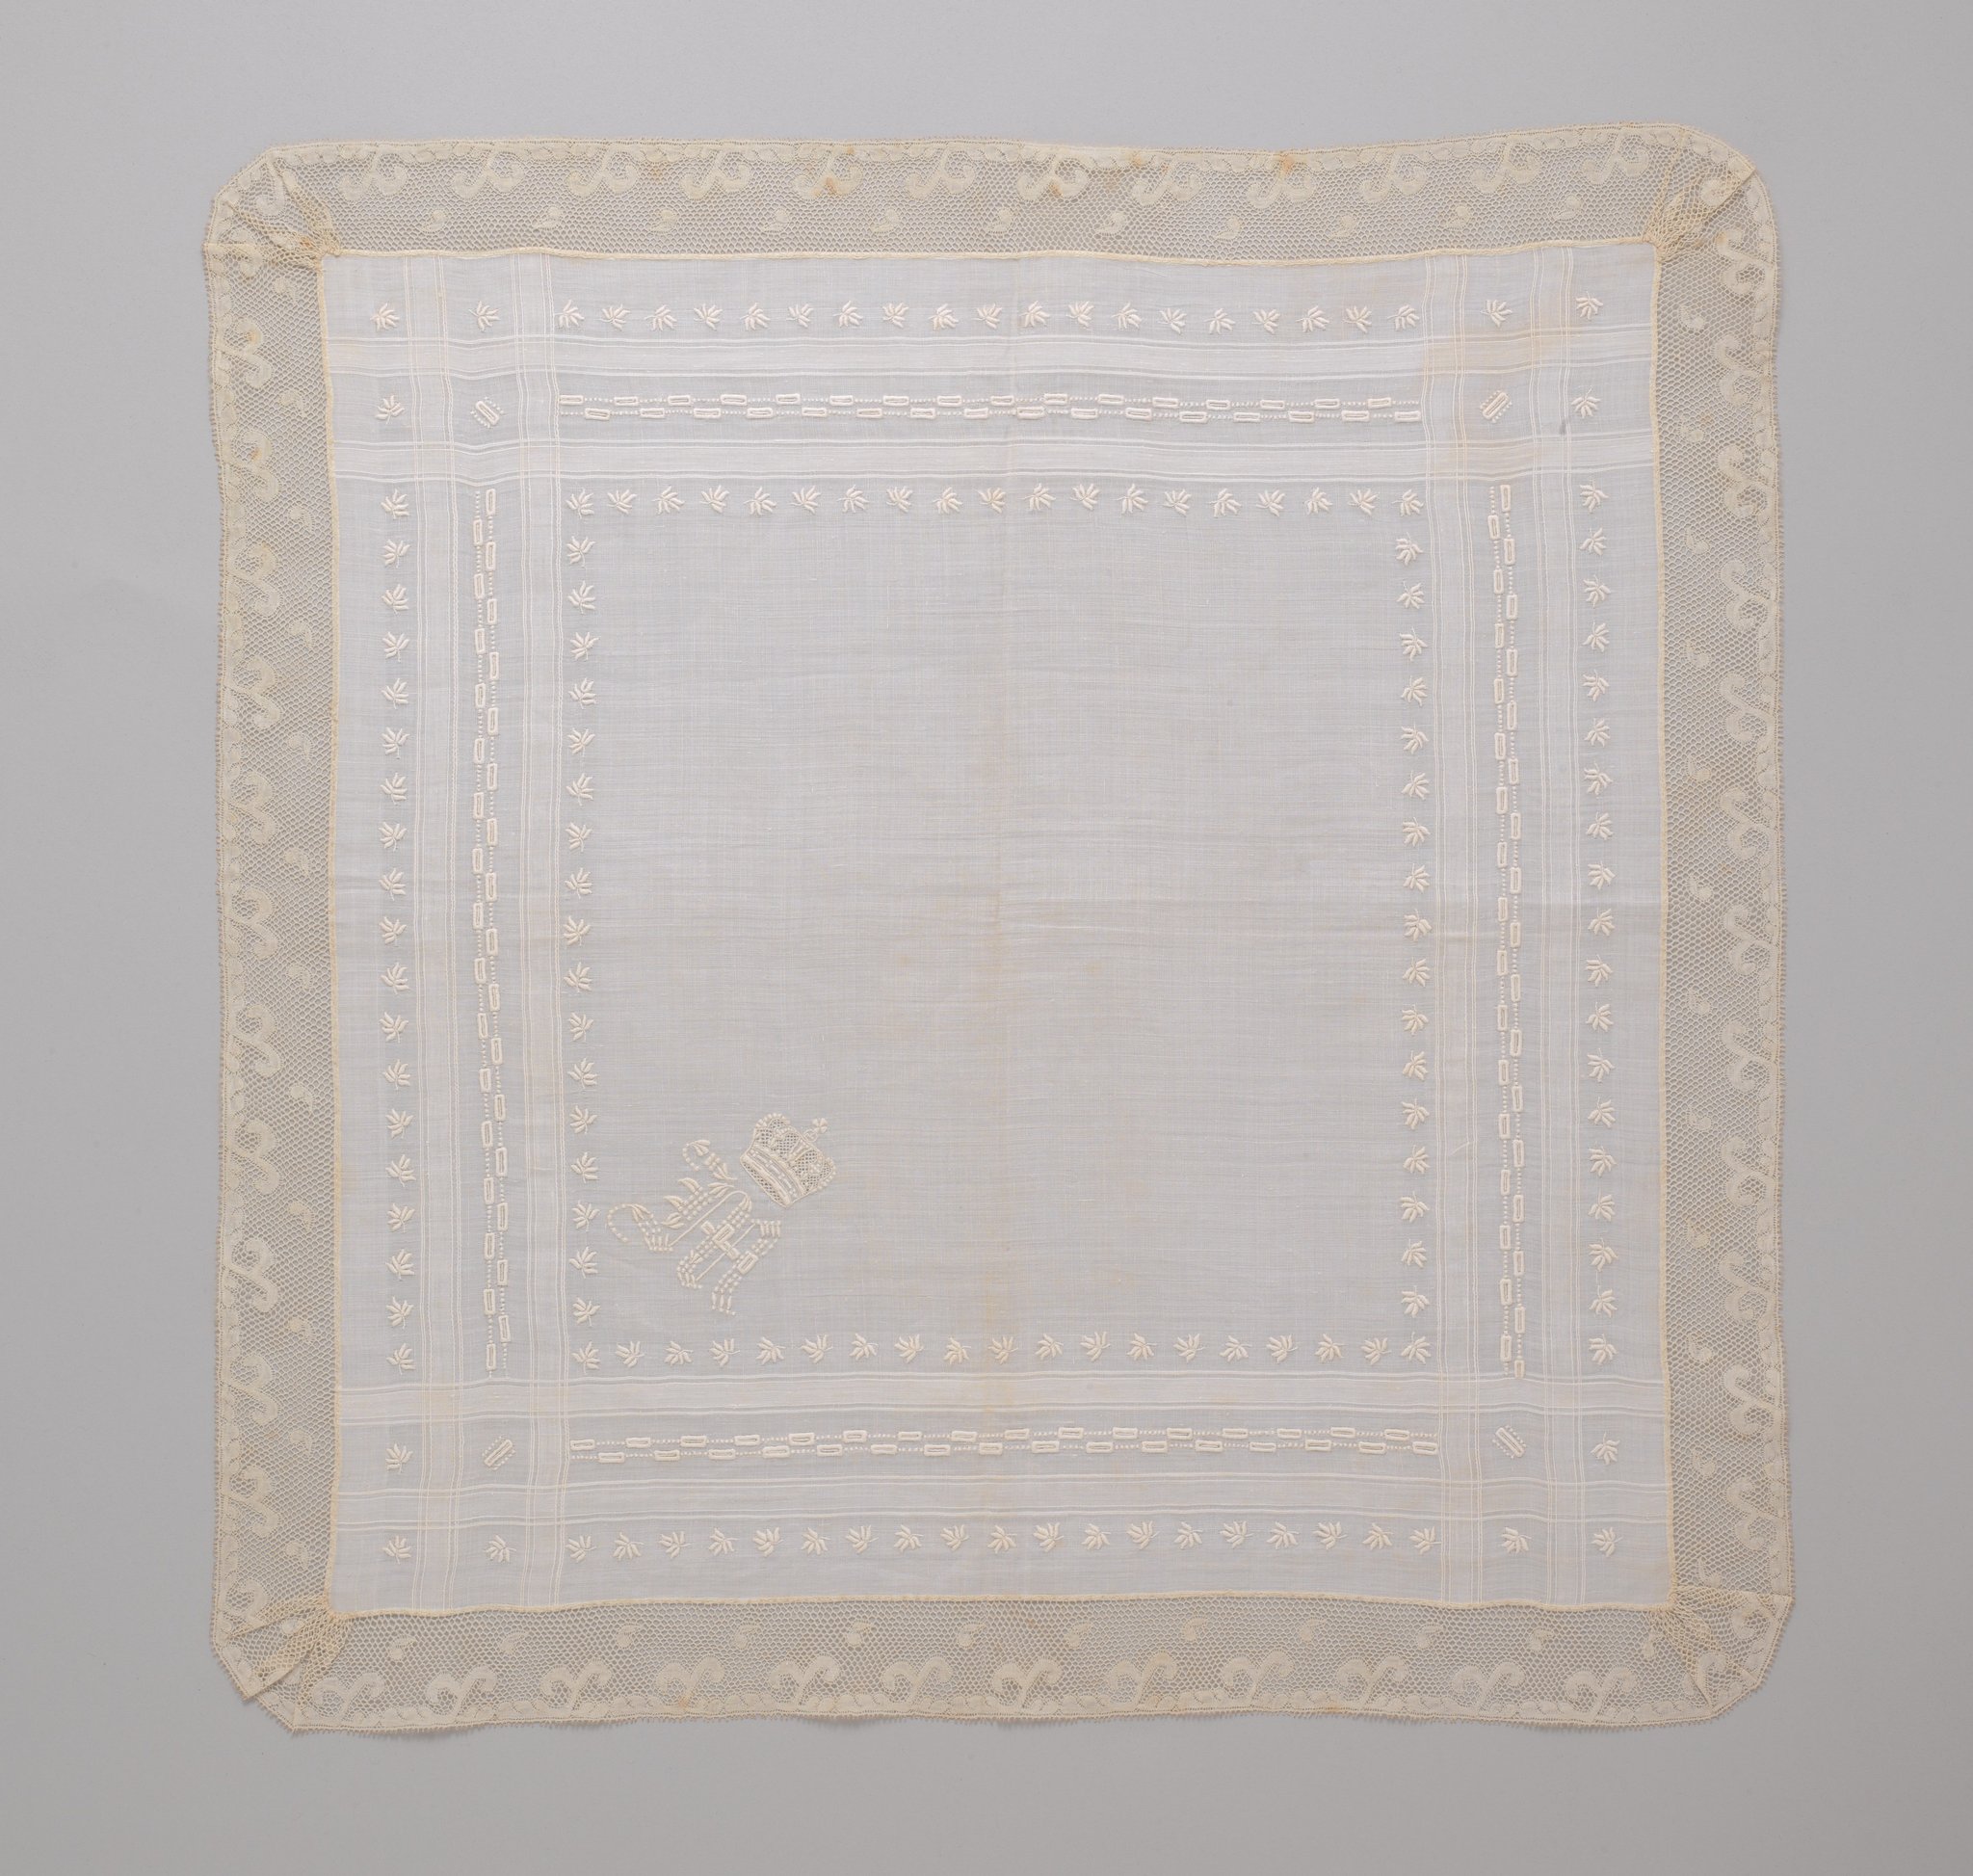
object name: handkerchief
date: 1840-1880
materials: linen, silk